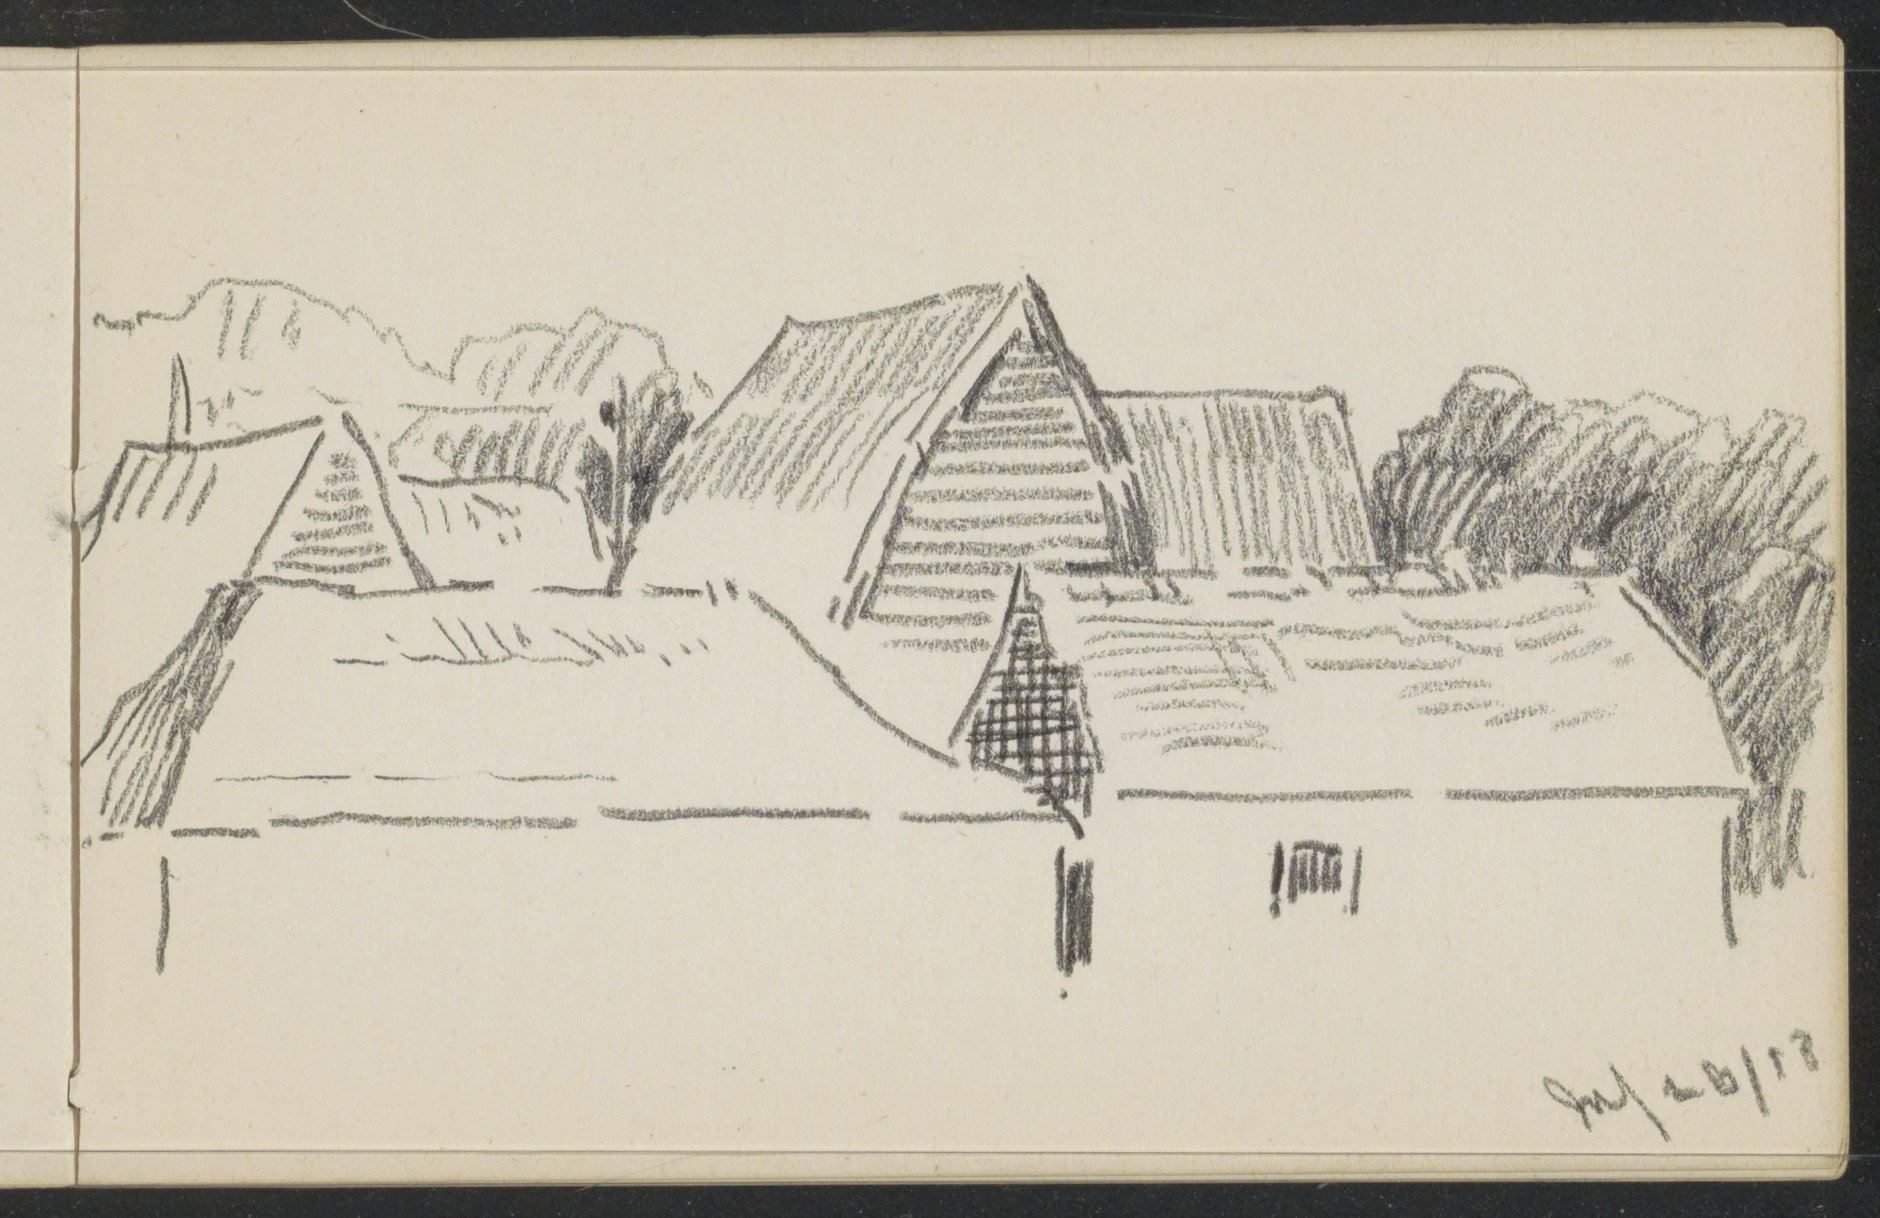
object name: sketchbook leaf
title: Gezicht op de daken van huizen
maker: alexander shilling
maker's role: draughtsman, print maker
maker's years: 1859-1937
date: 1907-1913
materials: chalk, paper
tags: roof (of house or building), village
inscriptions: date: ‘July 28/13’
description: Blad 4 recto uit een schetsboek met 30 bladen.